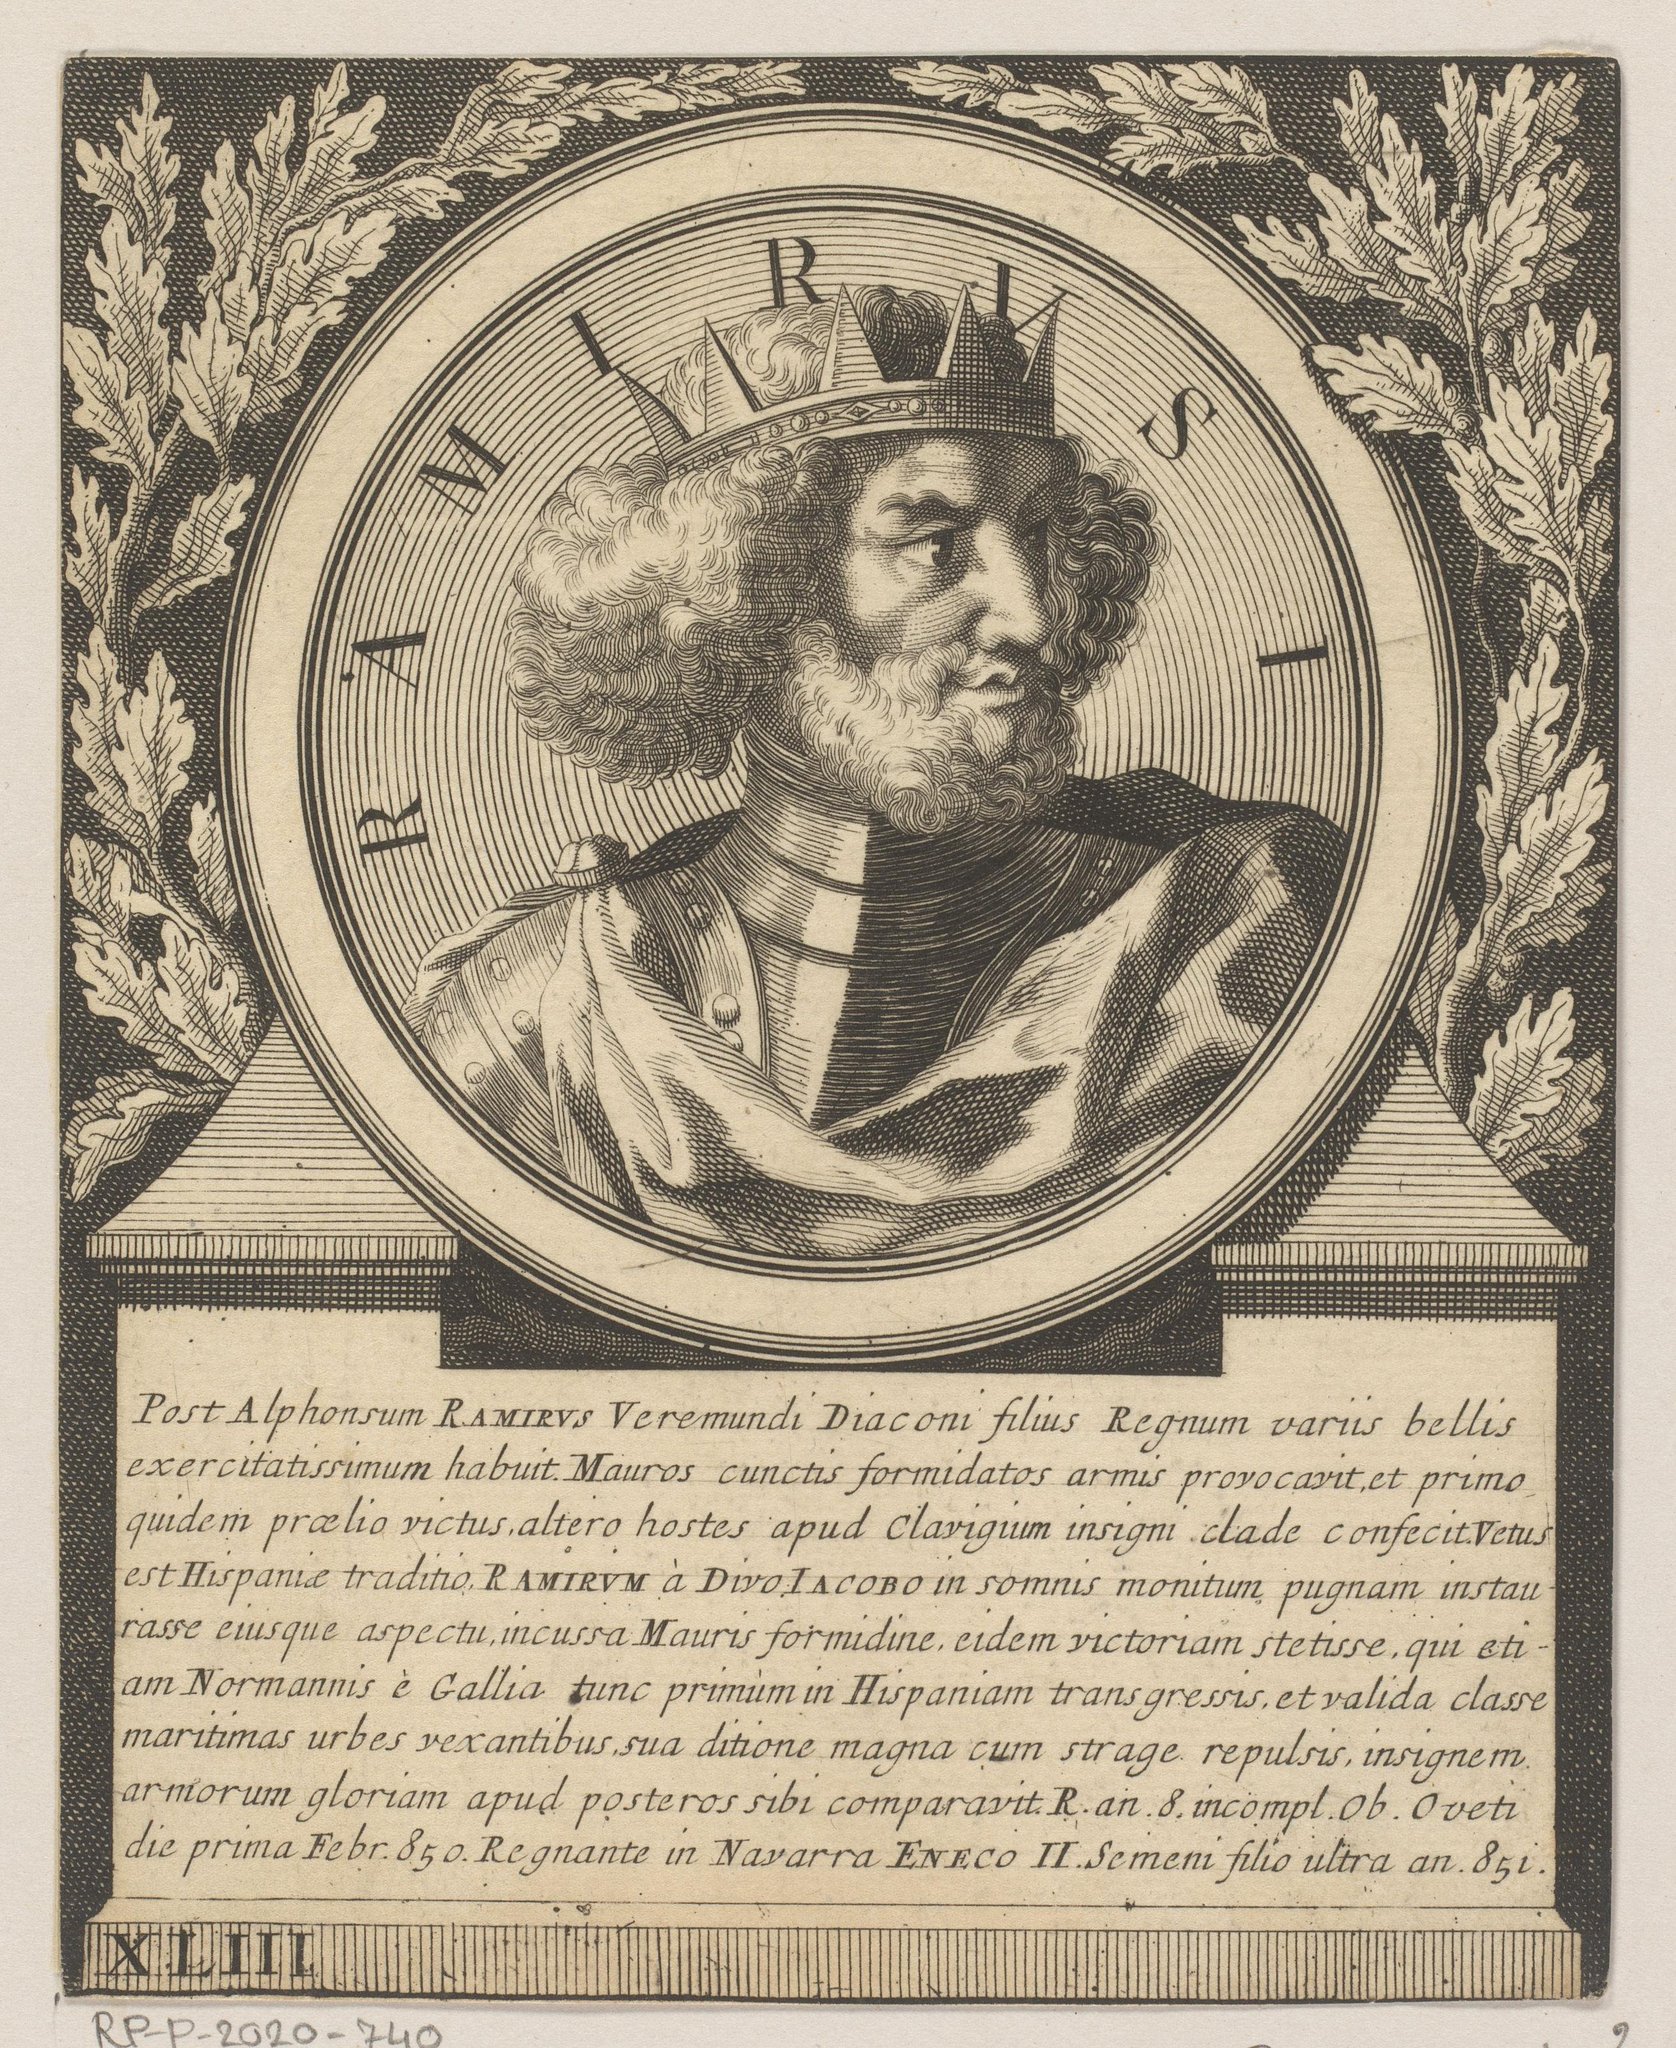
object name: print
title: Ramirus I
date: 1698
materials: paper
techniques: engraving, etching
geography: paris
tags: historical persons, ruler, sovereign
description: Portret afkomstig van een grote prent, getiteld 'Series Chronologica et Imagines Regum Hispaniae ab Ataulpho ad Carolum II', bestaande uit meerdere bladen die samengevoegd konden worden, uitgegeven door Petrus de la Tour in 1698.